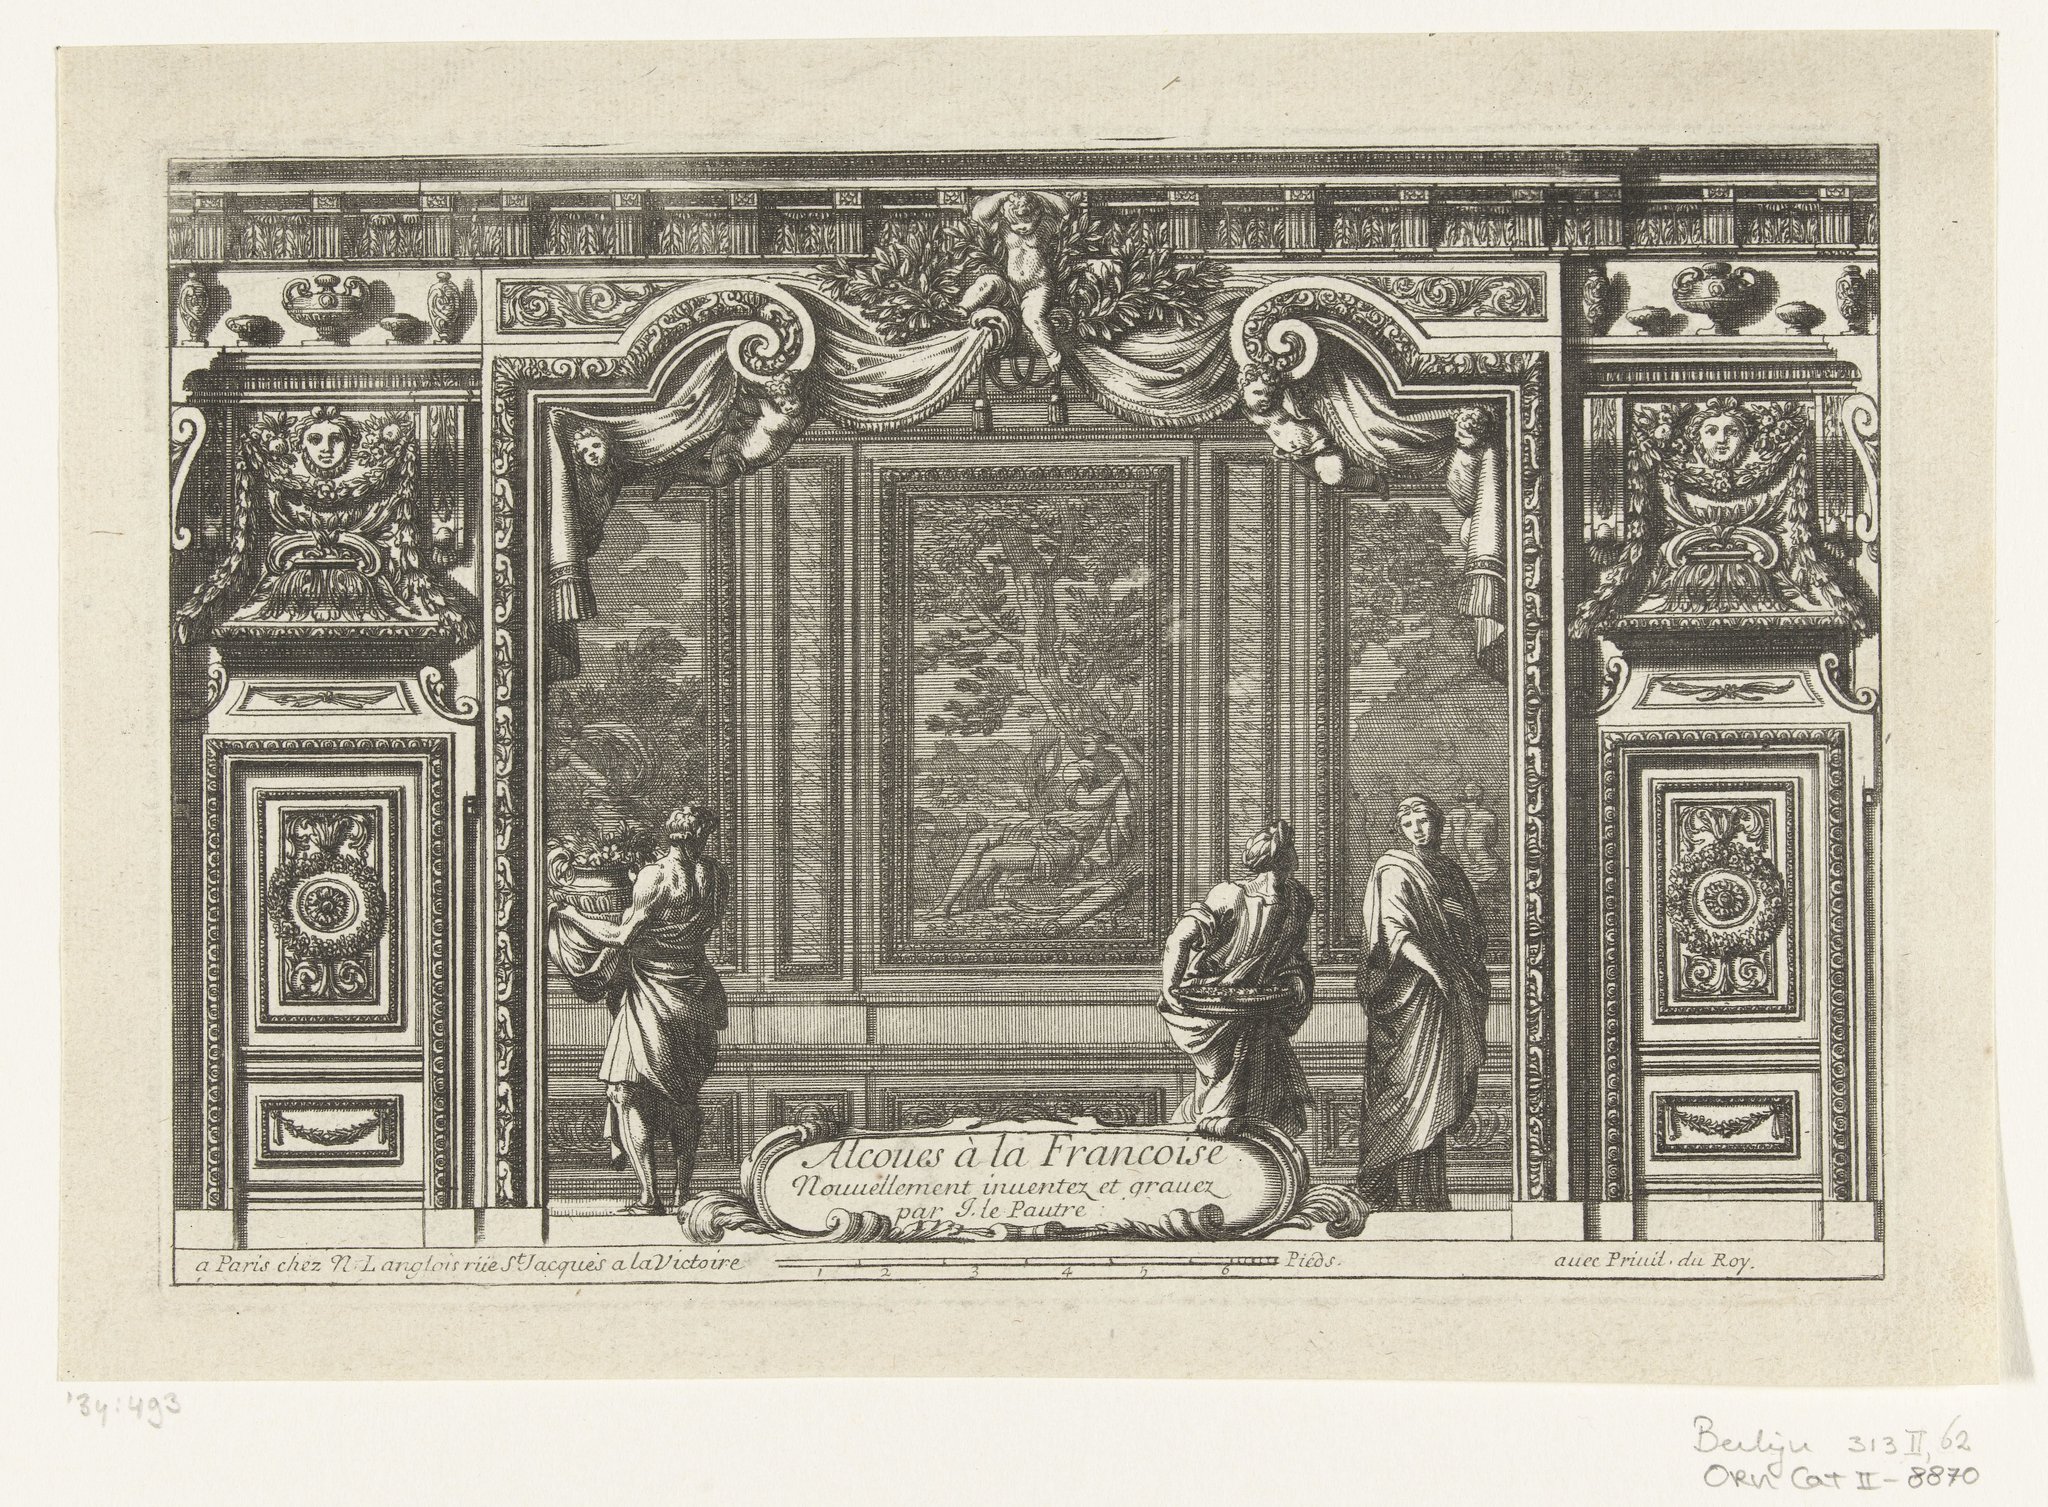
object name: print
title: Titelblad: Alcoves à la Francoise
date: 1678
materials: paper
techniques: etching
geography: paris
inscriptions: date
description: Alkoof, waarvan de achterste muur gedecoreerd is met schilderijen.